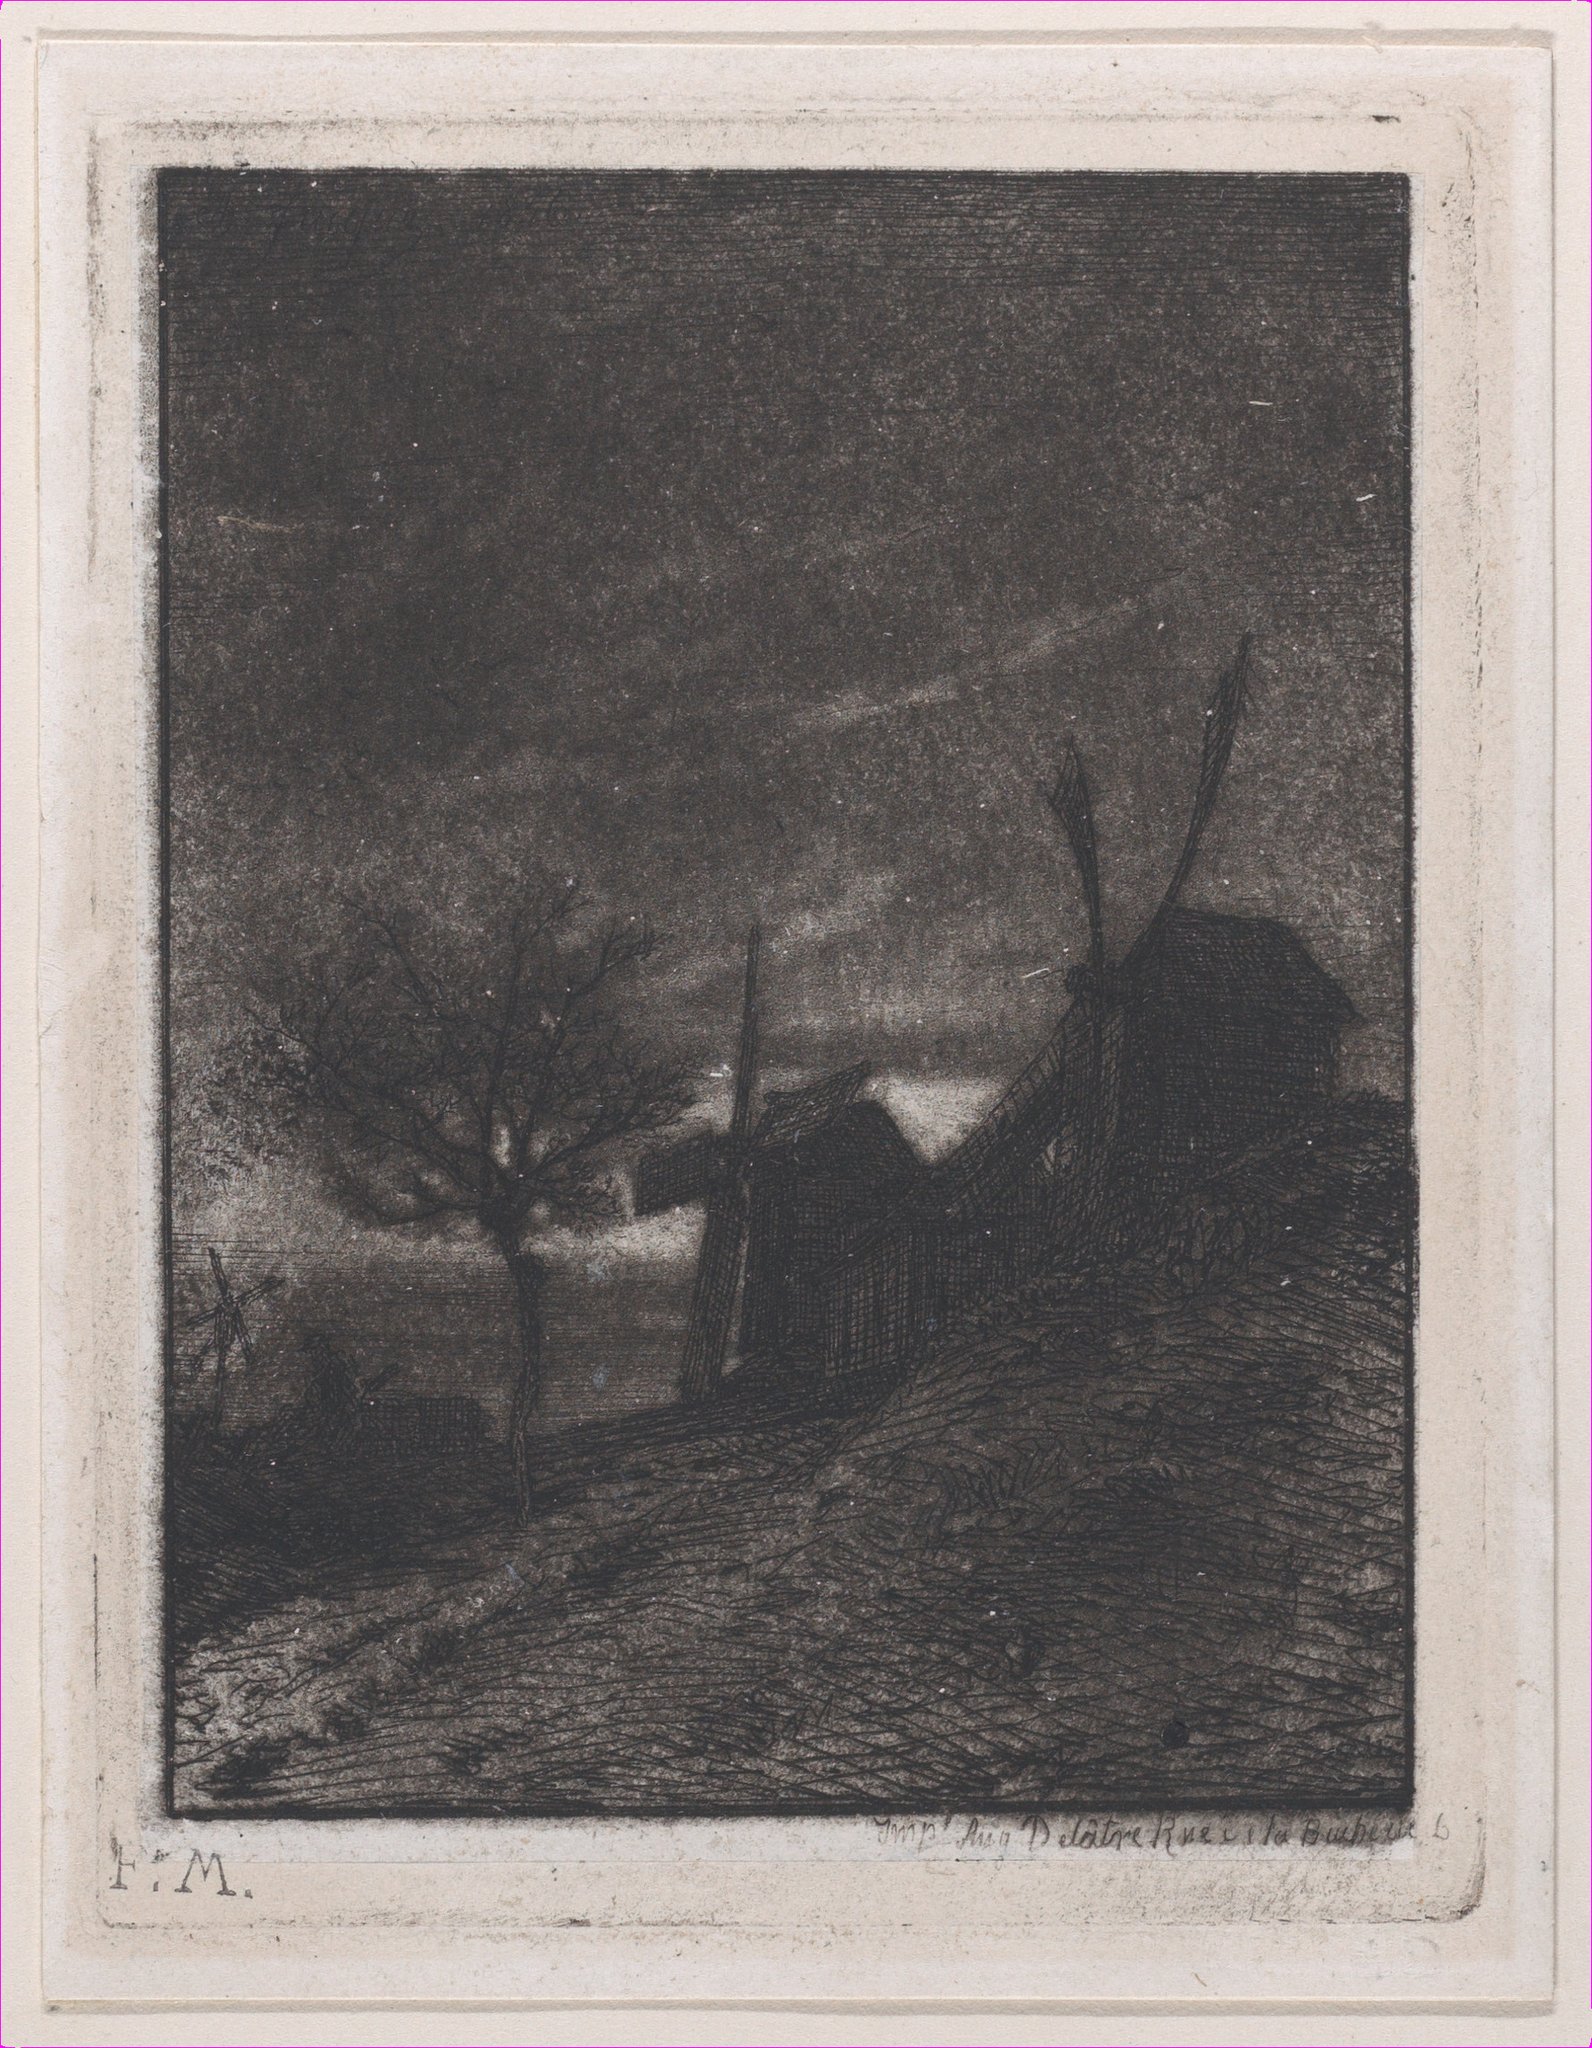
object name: print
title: Mills at Montmartre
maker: charles émile jacque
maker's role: artist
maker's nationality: french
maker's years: 1813-1894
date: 1846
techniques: etching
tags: windmills